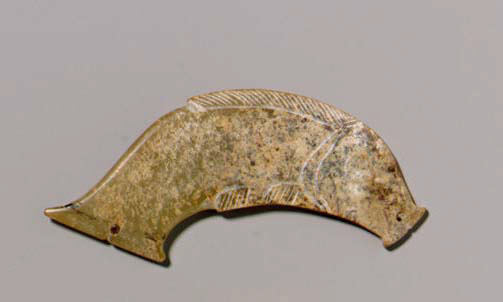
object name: plaque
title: Plaque in the Shape of a Fish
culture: chinese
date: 1200-1001 BCE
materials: jade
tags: fish